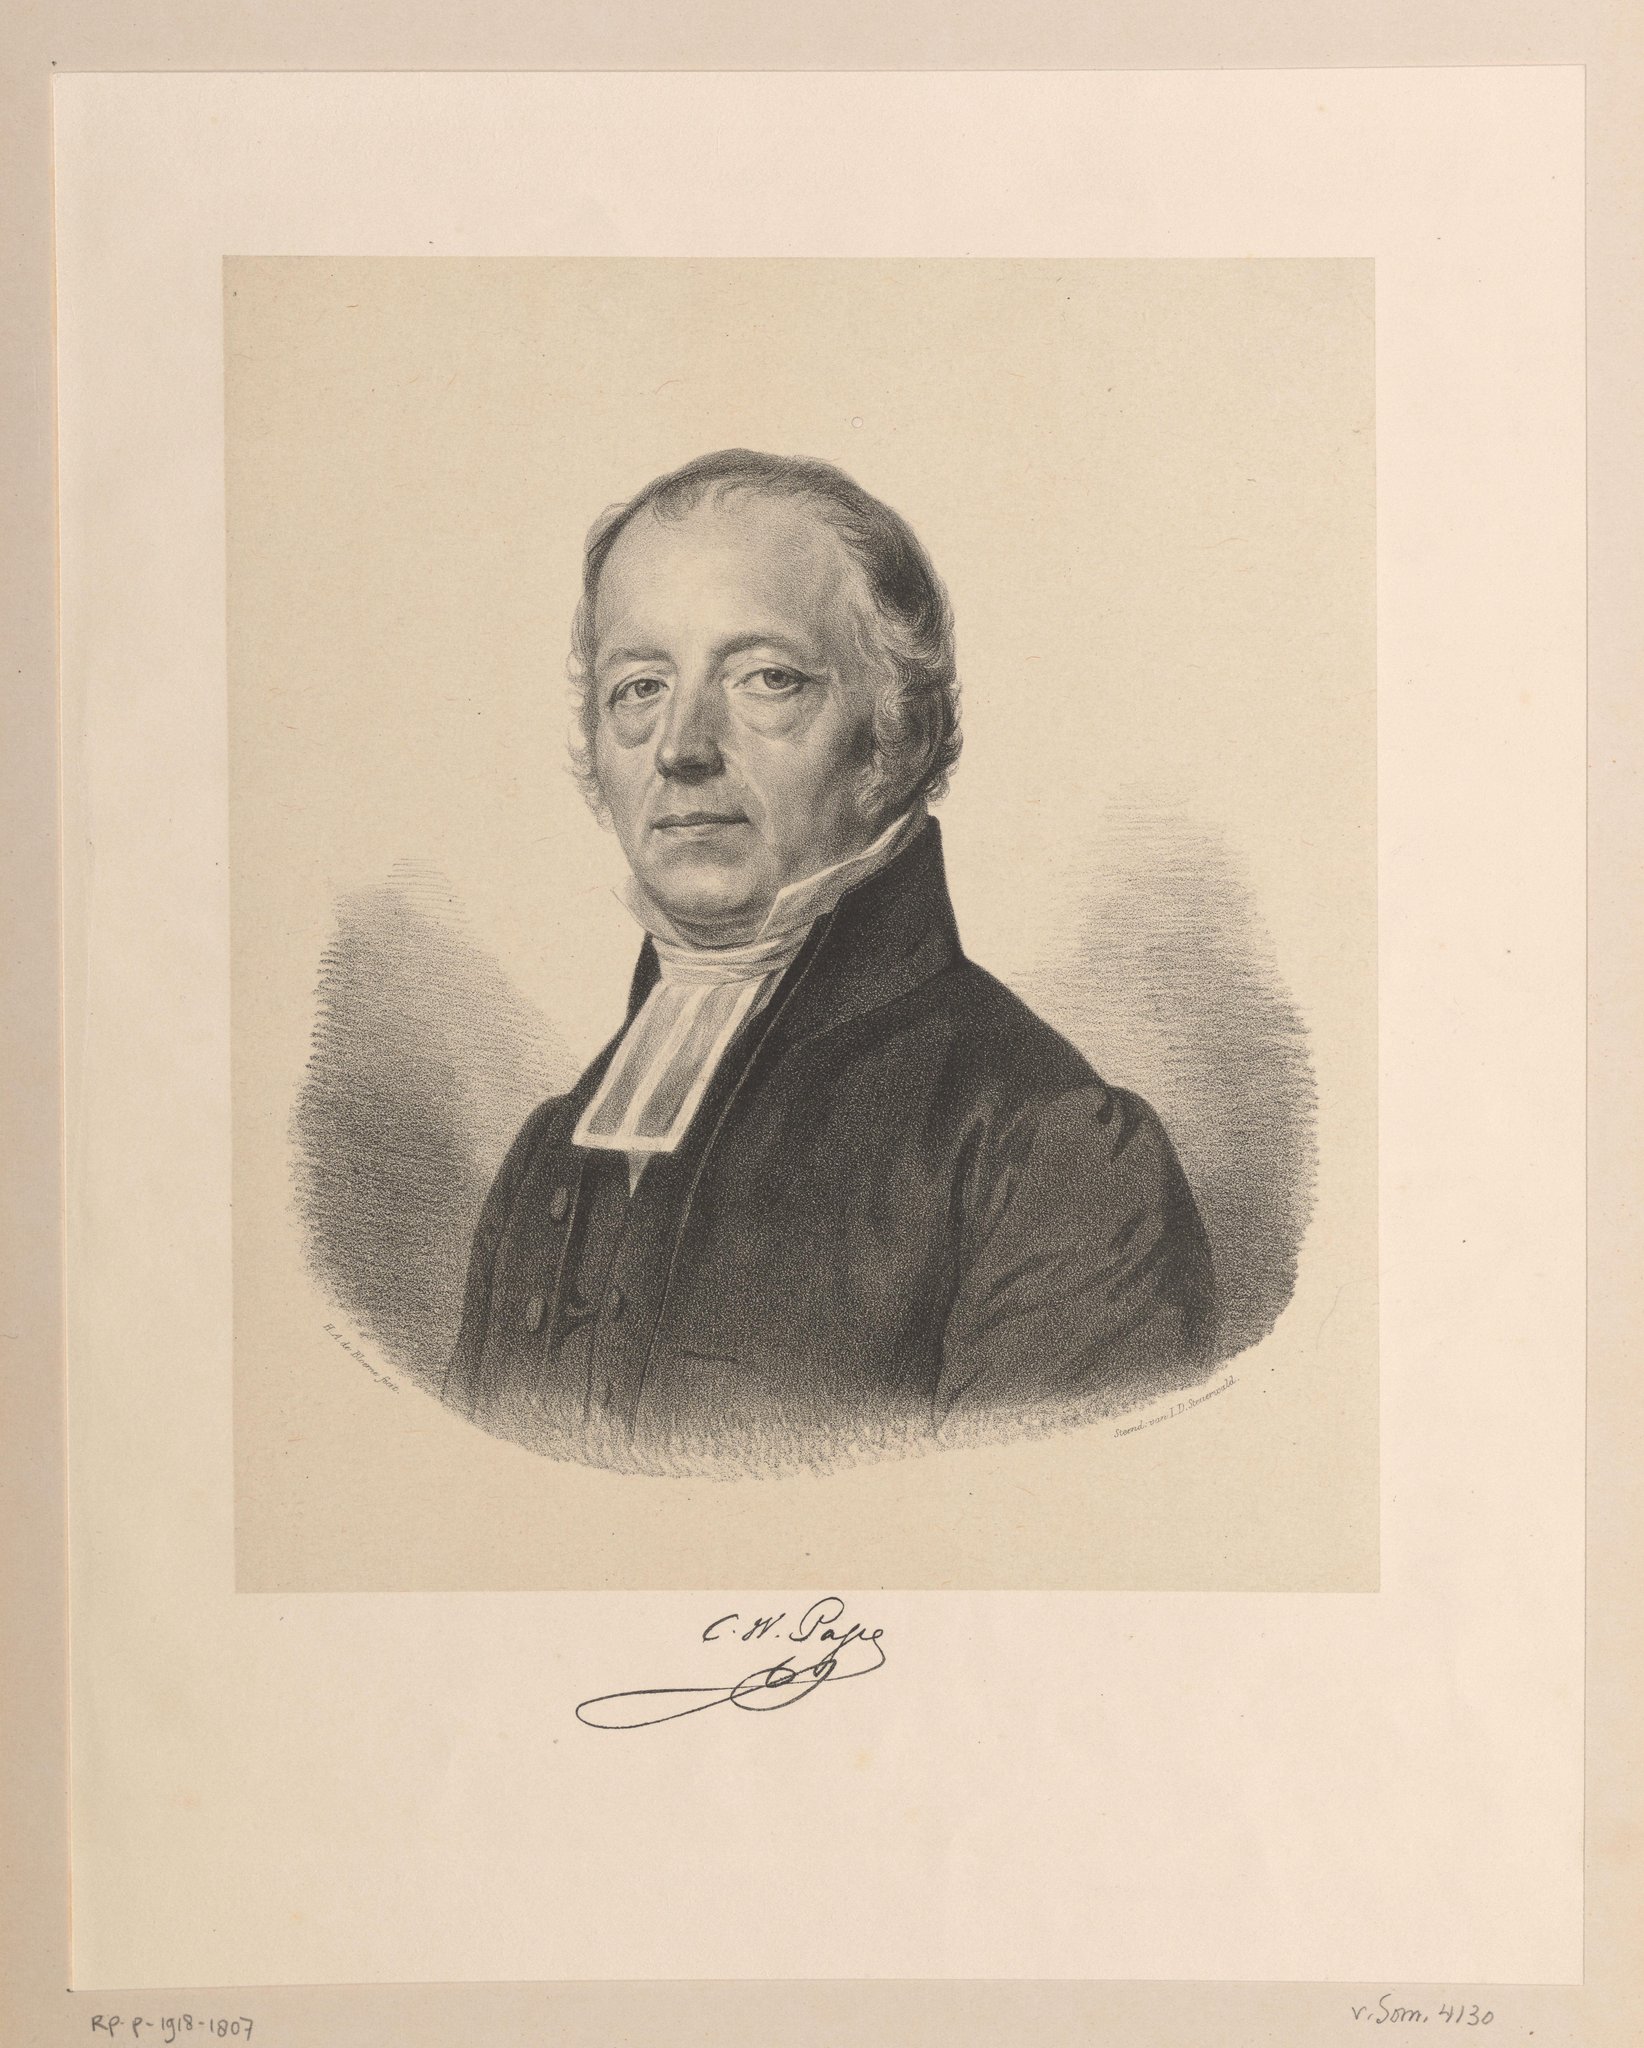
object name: print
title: Portret van Carel Willem Pape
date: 1822-1863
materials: paper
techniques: lithograph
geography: the hague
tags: the hague, adult man, historical persons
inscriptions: collector's mark: Lugt 2233